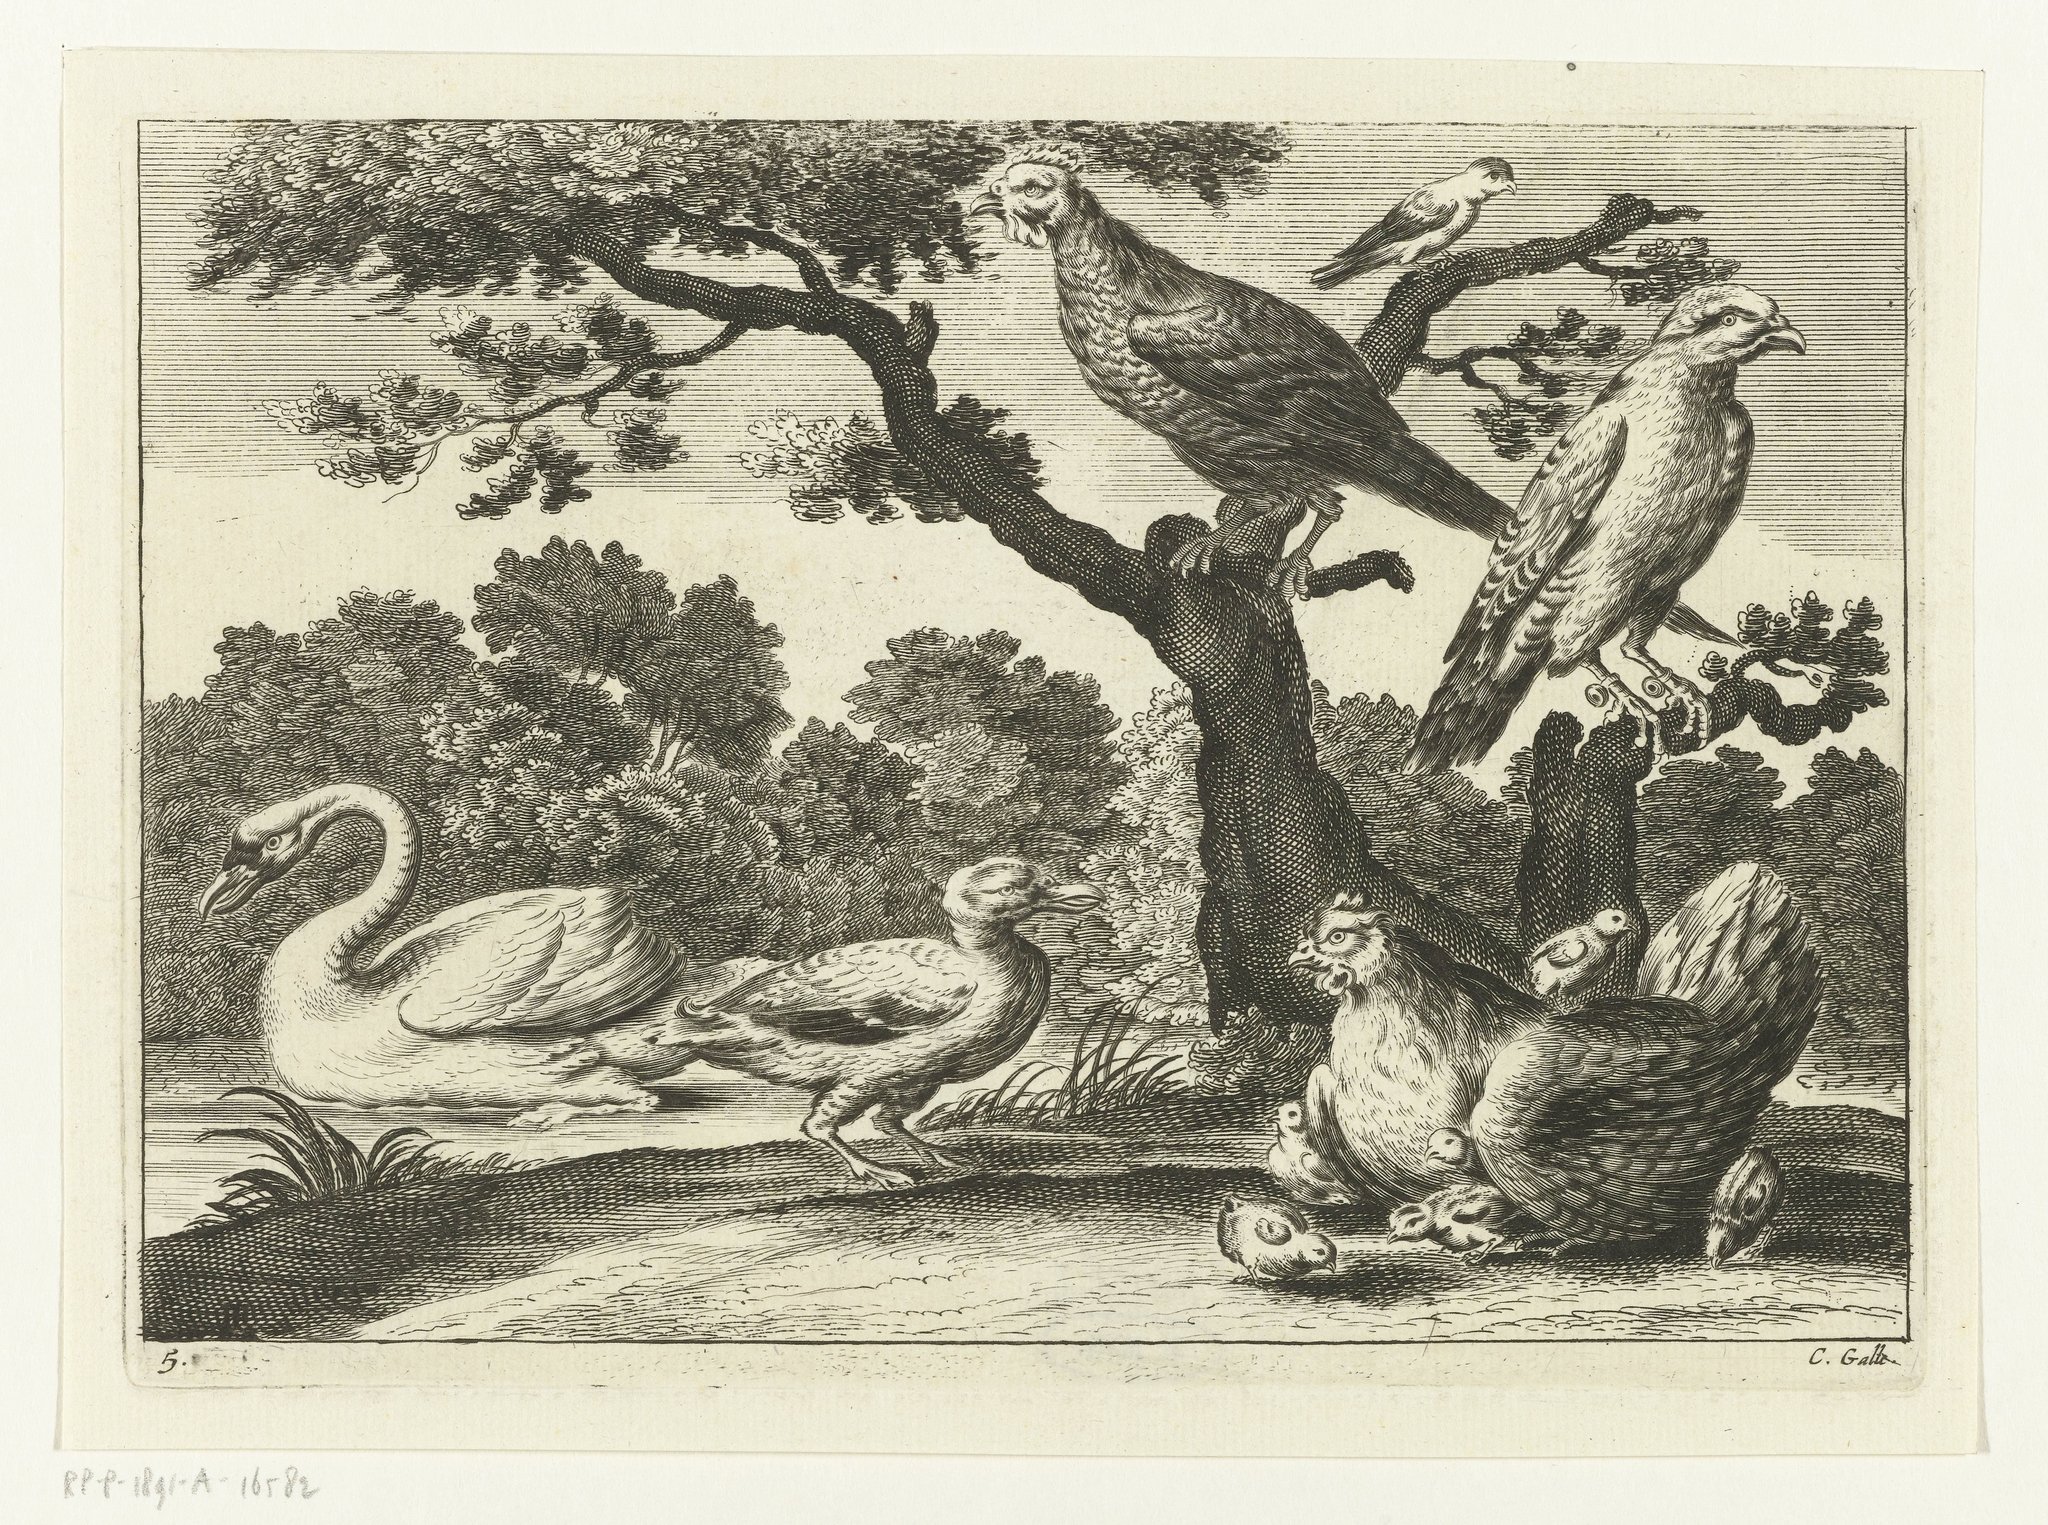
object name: print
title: Verschillende vogels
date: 1654-1678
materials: paper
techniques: engraving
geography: london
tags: water-birds: swan, birds, fowl (cock, hen, chicken, etc.), walker and runner birds: turkey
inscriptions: collector's mark: Lugt 2228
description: Prent maakt deel uit van de zeventiendelige serie met voorstellingen van verschillende vogels: "Diversarum avium species".